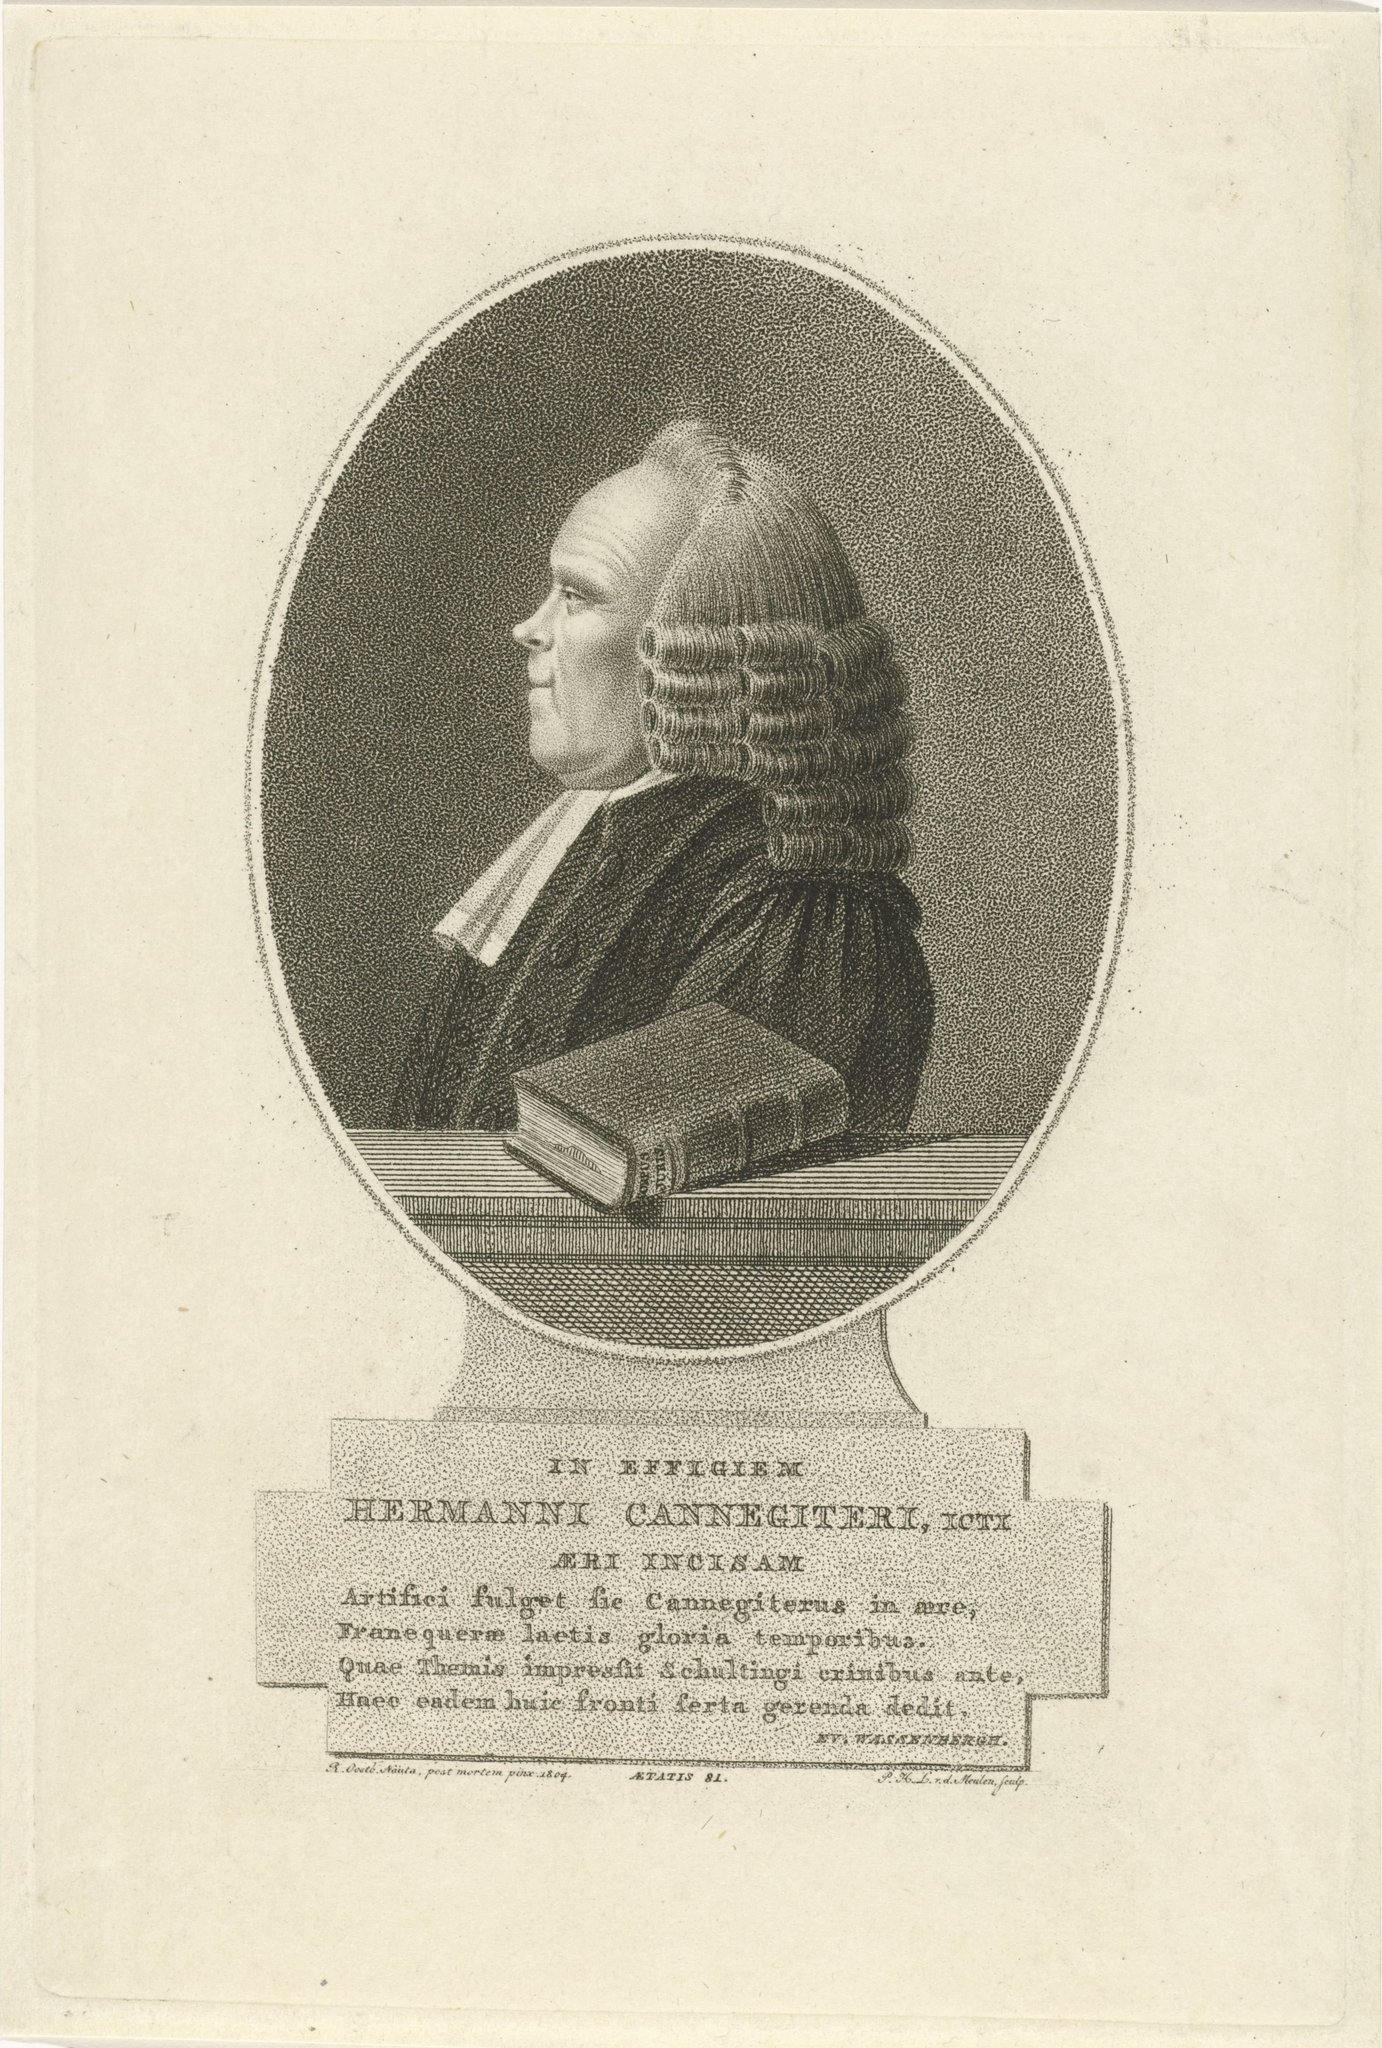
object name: print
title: Portret van Herman Cannegieter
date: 1804-1806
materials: paper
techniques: etching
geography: amsterdam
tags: arnhem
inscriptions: collector's mark: Lugt 2228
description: Portret van rechtsgeleerde Herman Cannegieter op 81-jarige leeftijd. Onder het portret een vierregelige tekst in het Latijn.